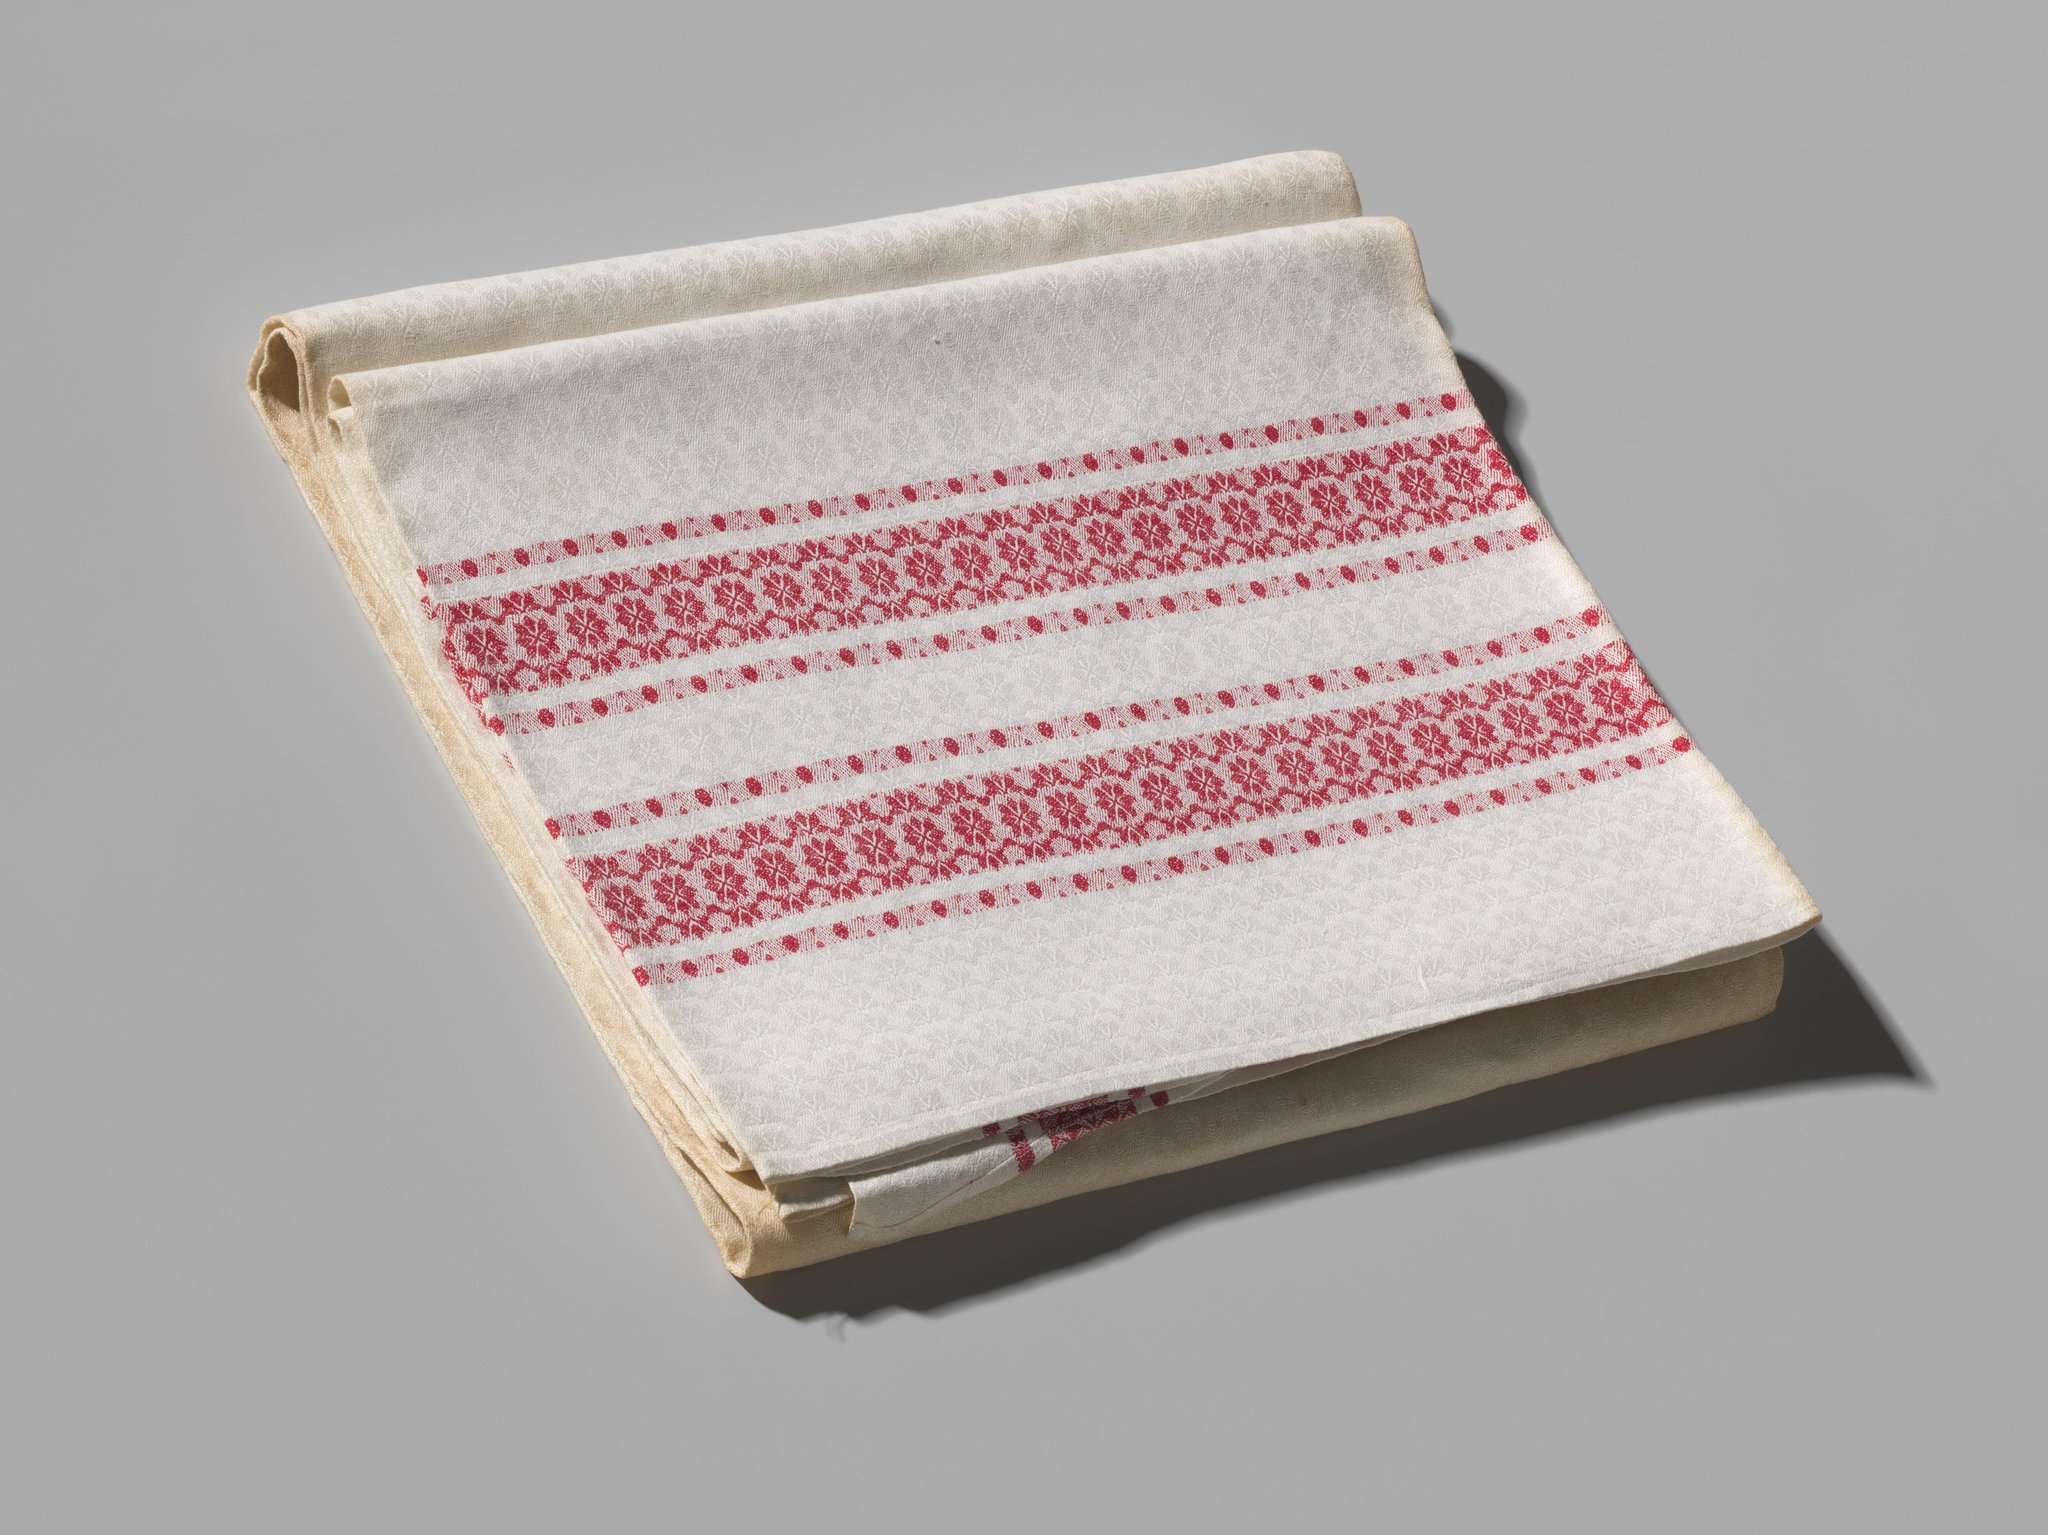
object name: tablecloth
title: Tafellaken met sterren en moesjes en rood ingeweven randen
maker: Anonymous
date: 1900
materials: linen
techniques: damask, weave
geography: netherlands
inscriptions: monogram: ‘P’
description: Tafellaken van linnendamast met rode ingeweven randen. Het patroon heeft sterren (of bloemen) en moesjes. De dubbele randen hebben sterren (of bloemen) en bladeren, geflankeerd door smalle randen met moesjes. In een hoek een in wit geborduurde letter P. Bij het tafellaken horen twaalf vingerdoeken (BK-1980-164-A t/m BK-1980-164-L).